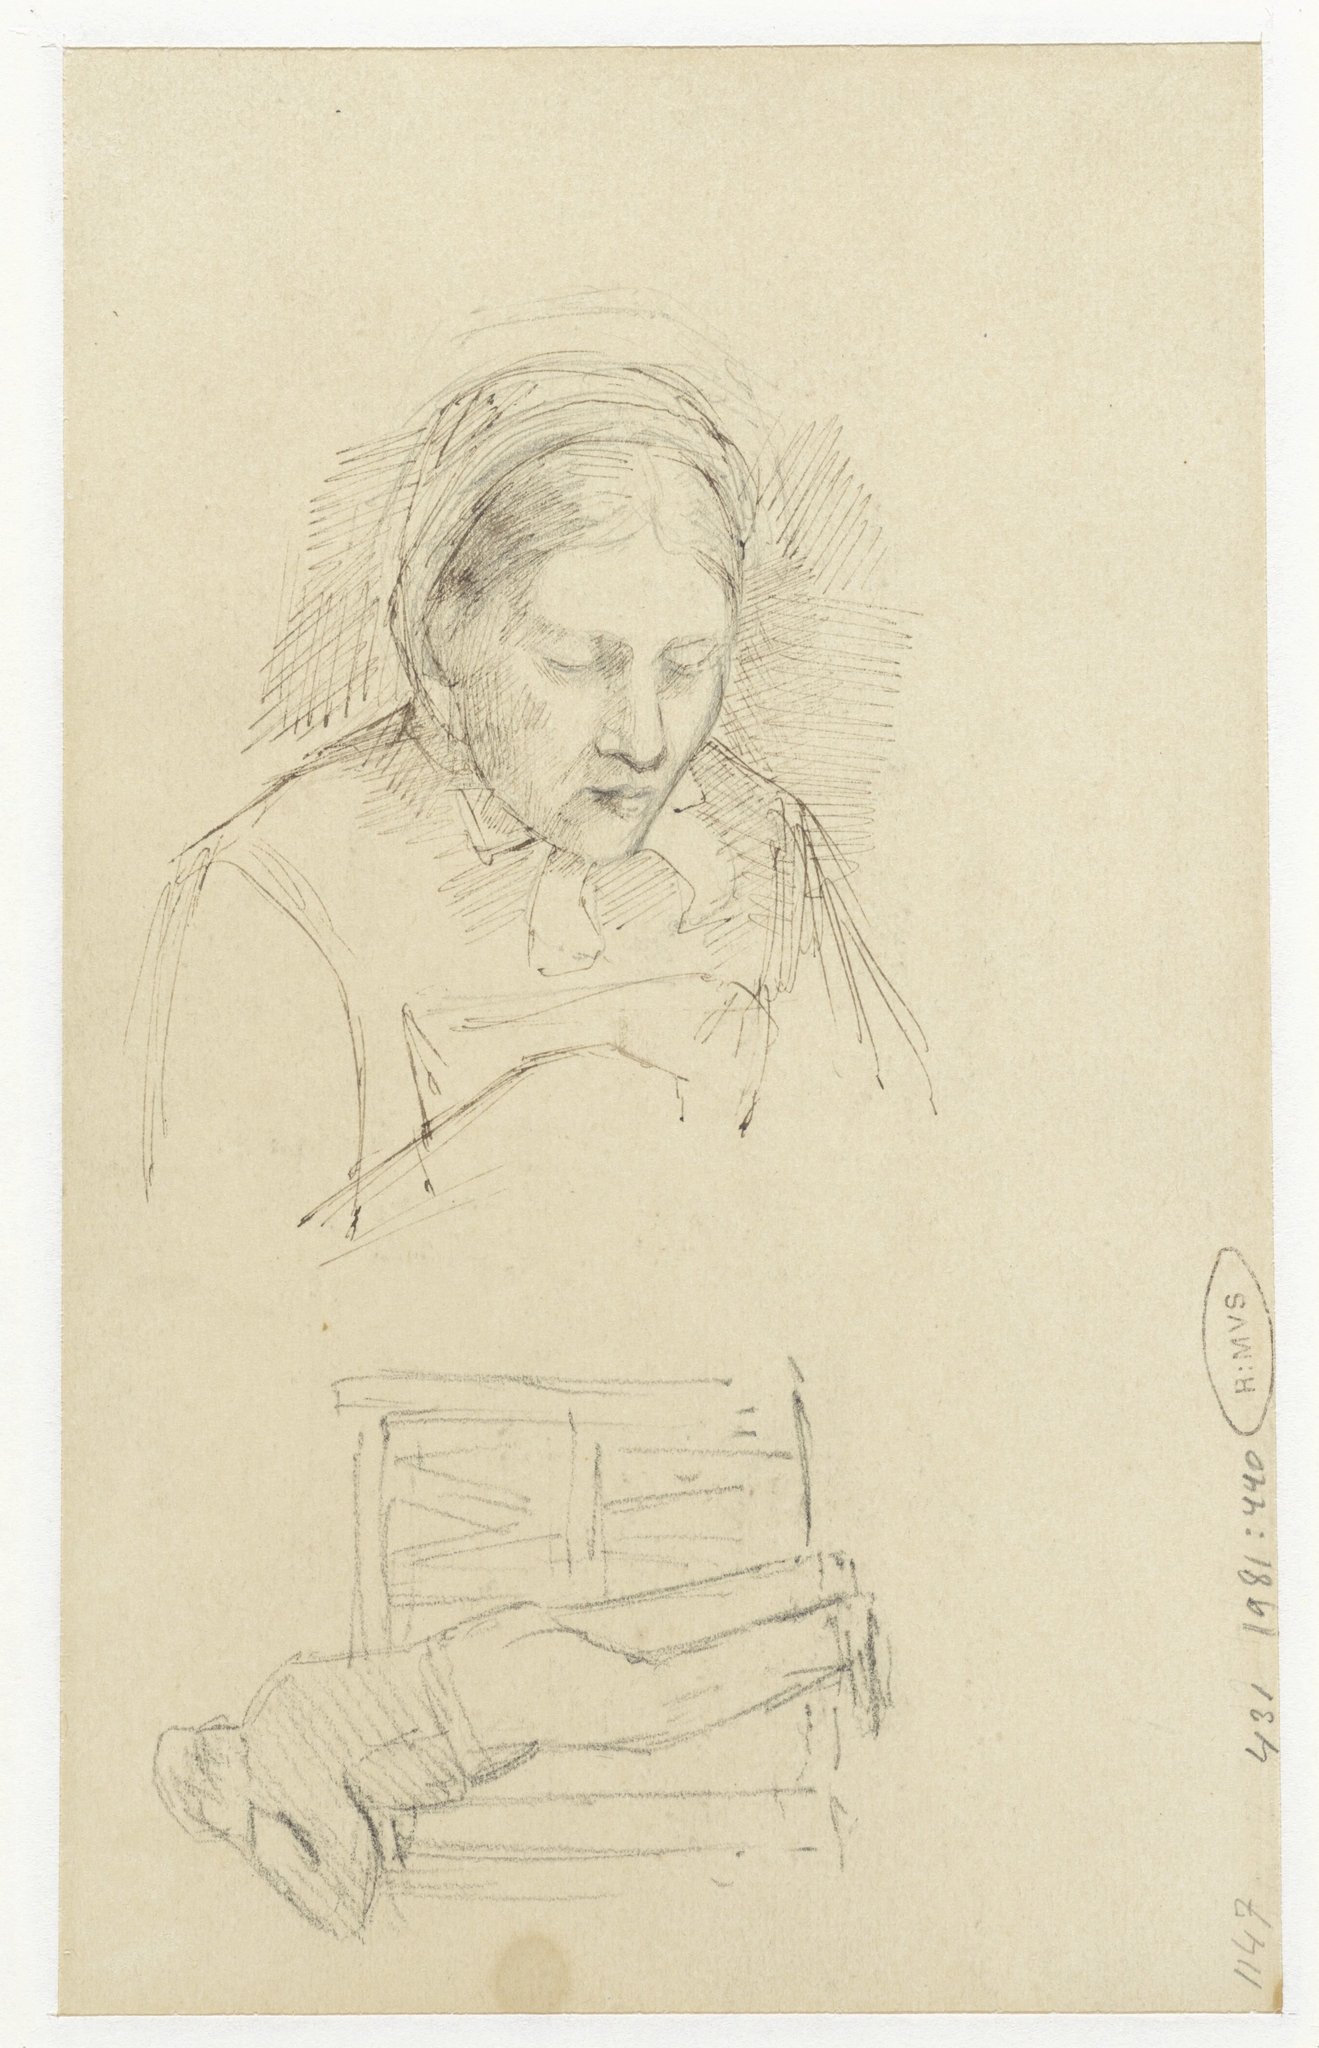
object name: drawing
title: Handwerkende vrouw en schets van een boer bij een hek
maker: jozef israëls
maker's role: draughtsman, painter, print maker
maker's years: 1824-1911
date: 1834-1911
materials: chalk, ink, paper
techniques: pen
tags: (other forms of) needlework, e.g.: crocheting, knitting, embroidering